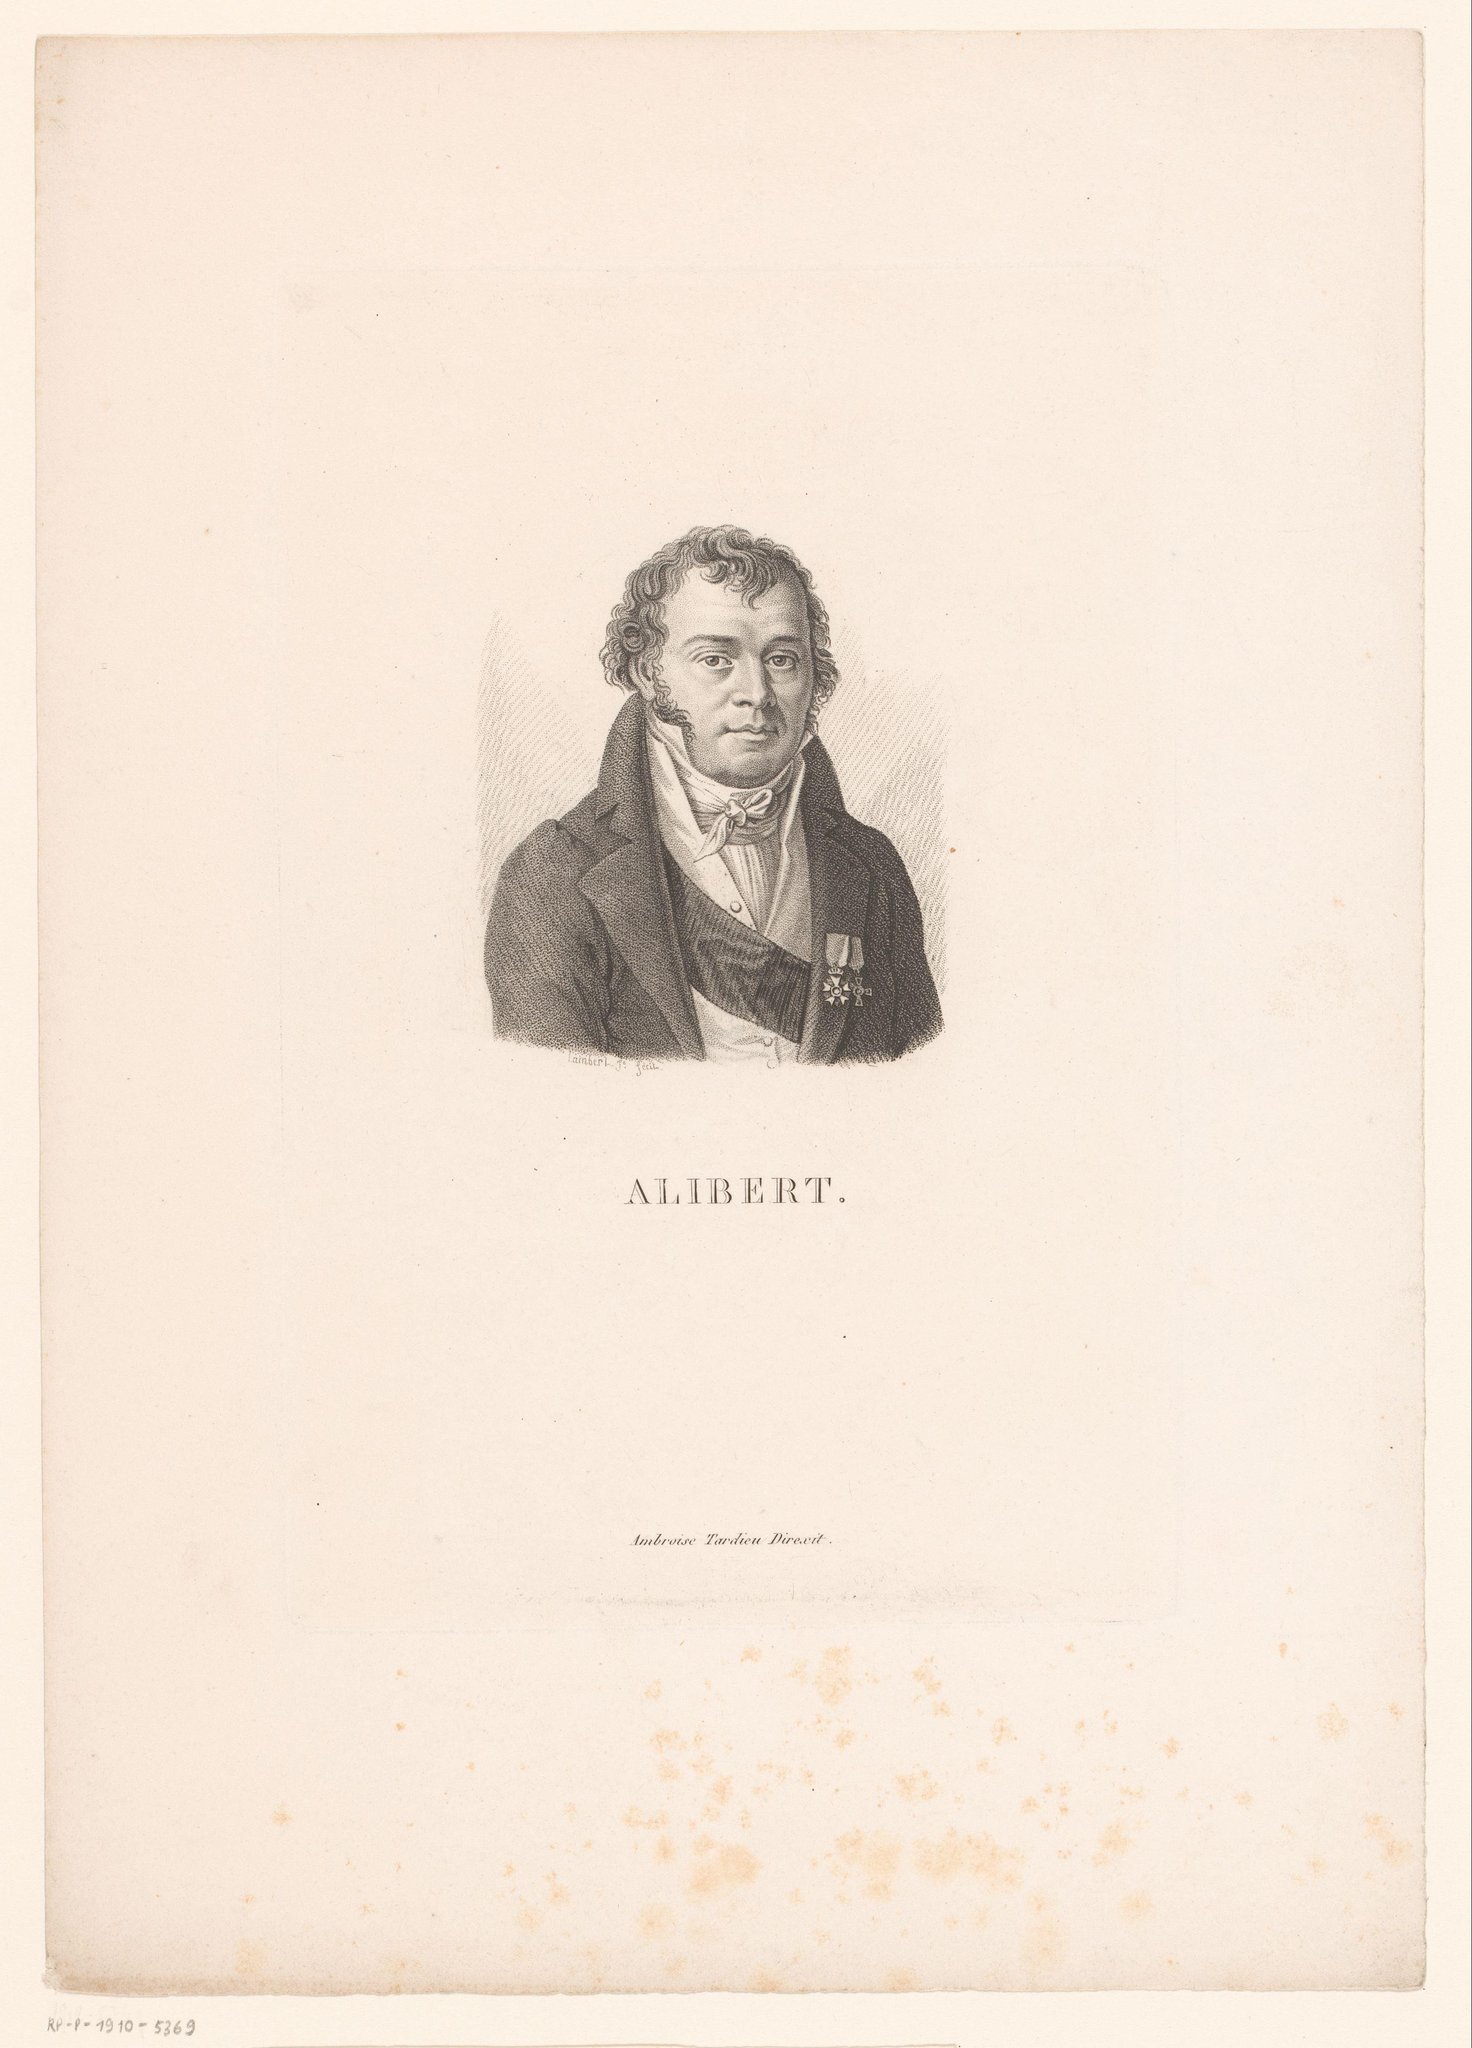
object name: print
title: Portret van Jean-Louis-Marc Alibert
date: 1812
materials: paper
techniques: etching, roulette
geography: paris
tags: historical persons, physician, doctor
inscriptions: collector's mark: Lugt 2228